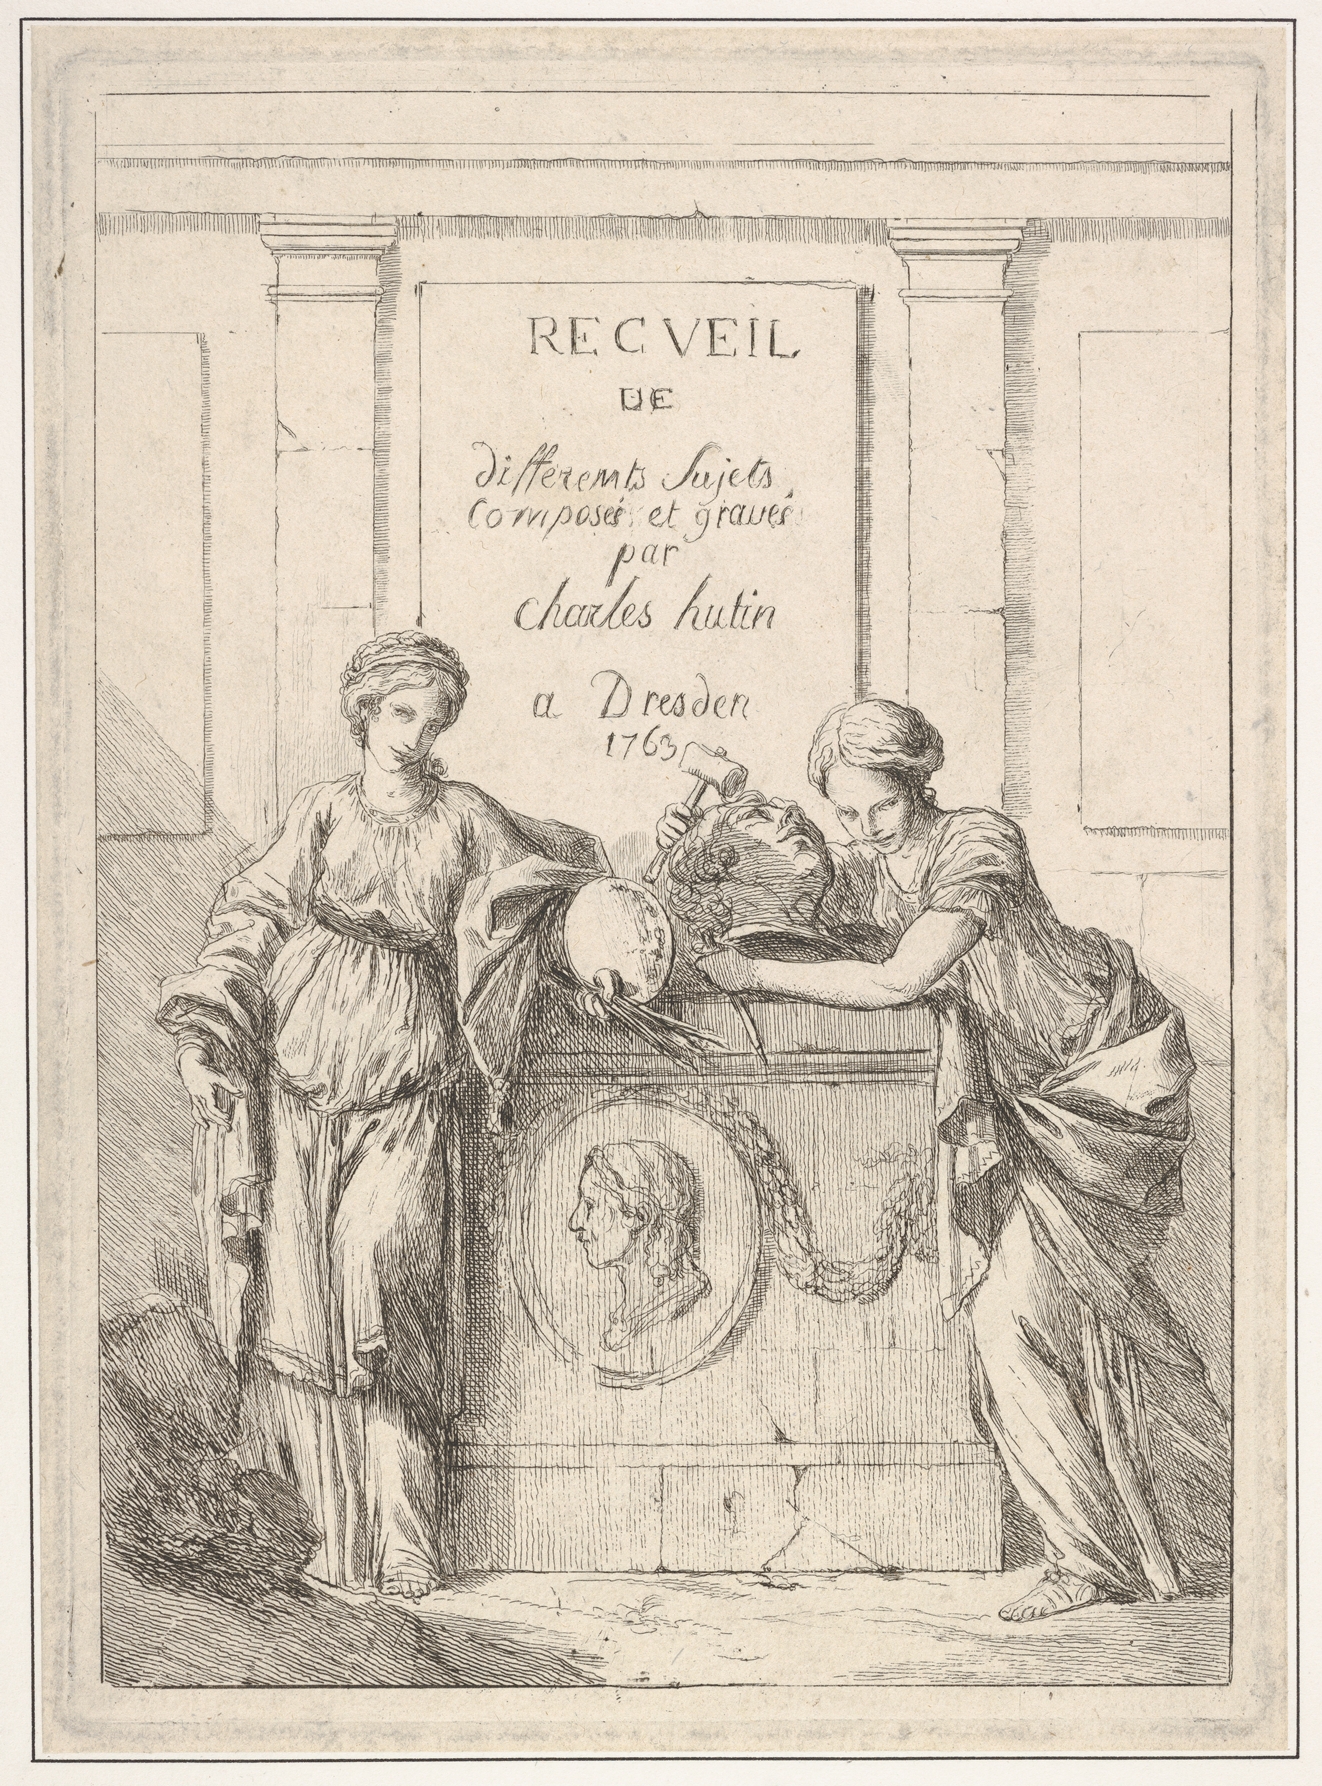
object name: print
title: Recueil de Différents Sujets composés et gravés par Charles Hutin à Dresden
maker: charles françois hutin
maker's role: artist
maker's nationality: french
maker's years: 1715-1776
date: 1763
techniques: etching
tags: profiles,women